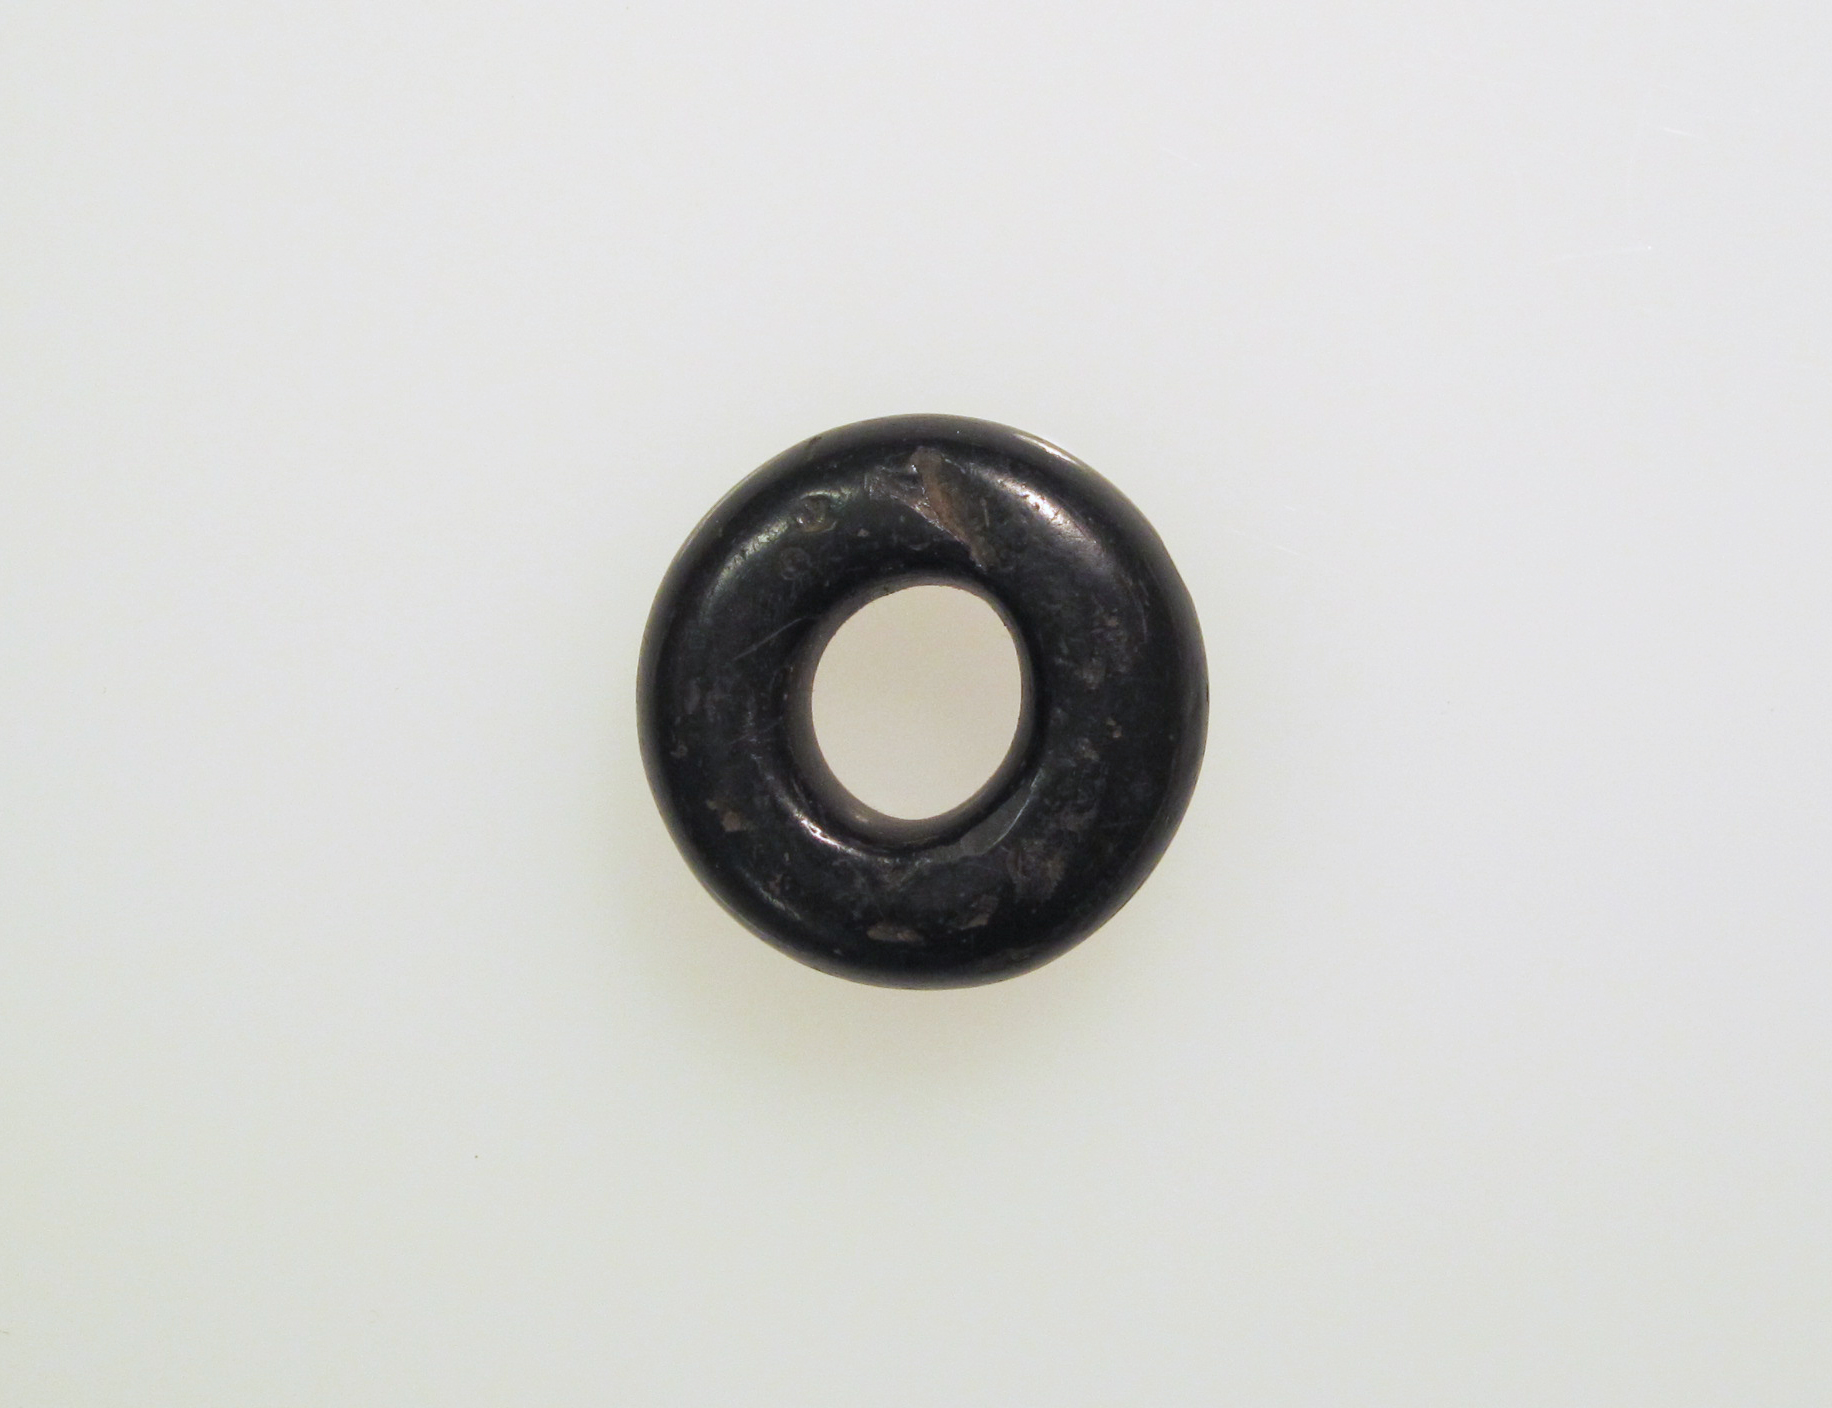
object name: ring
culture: roman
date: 670 BCE-330 CE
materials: glass